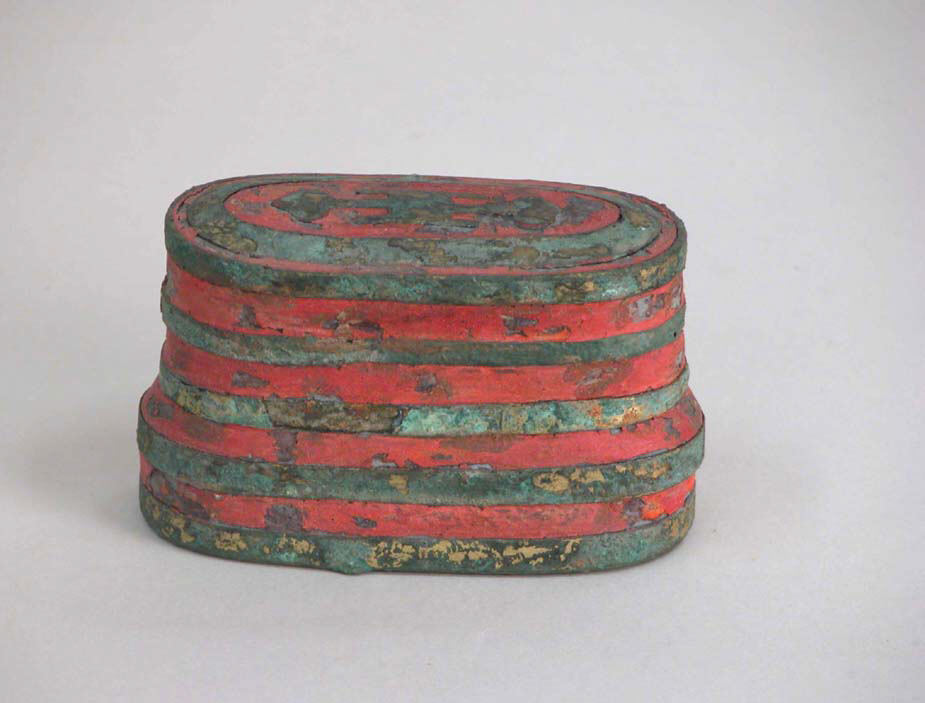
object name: bowl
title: Oval Bowl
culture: chinese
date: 206 BCE-220 CE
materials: gilt bronze, lacquer